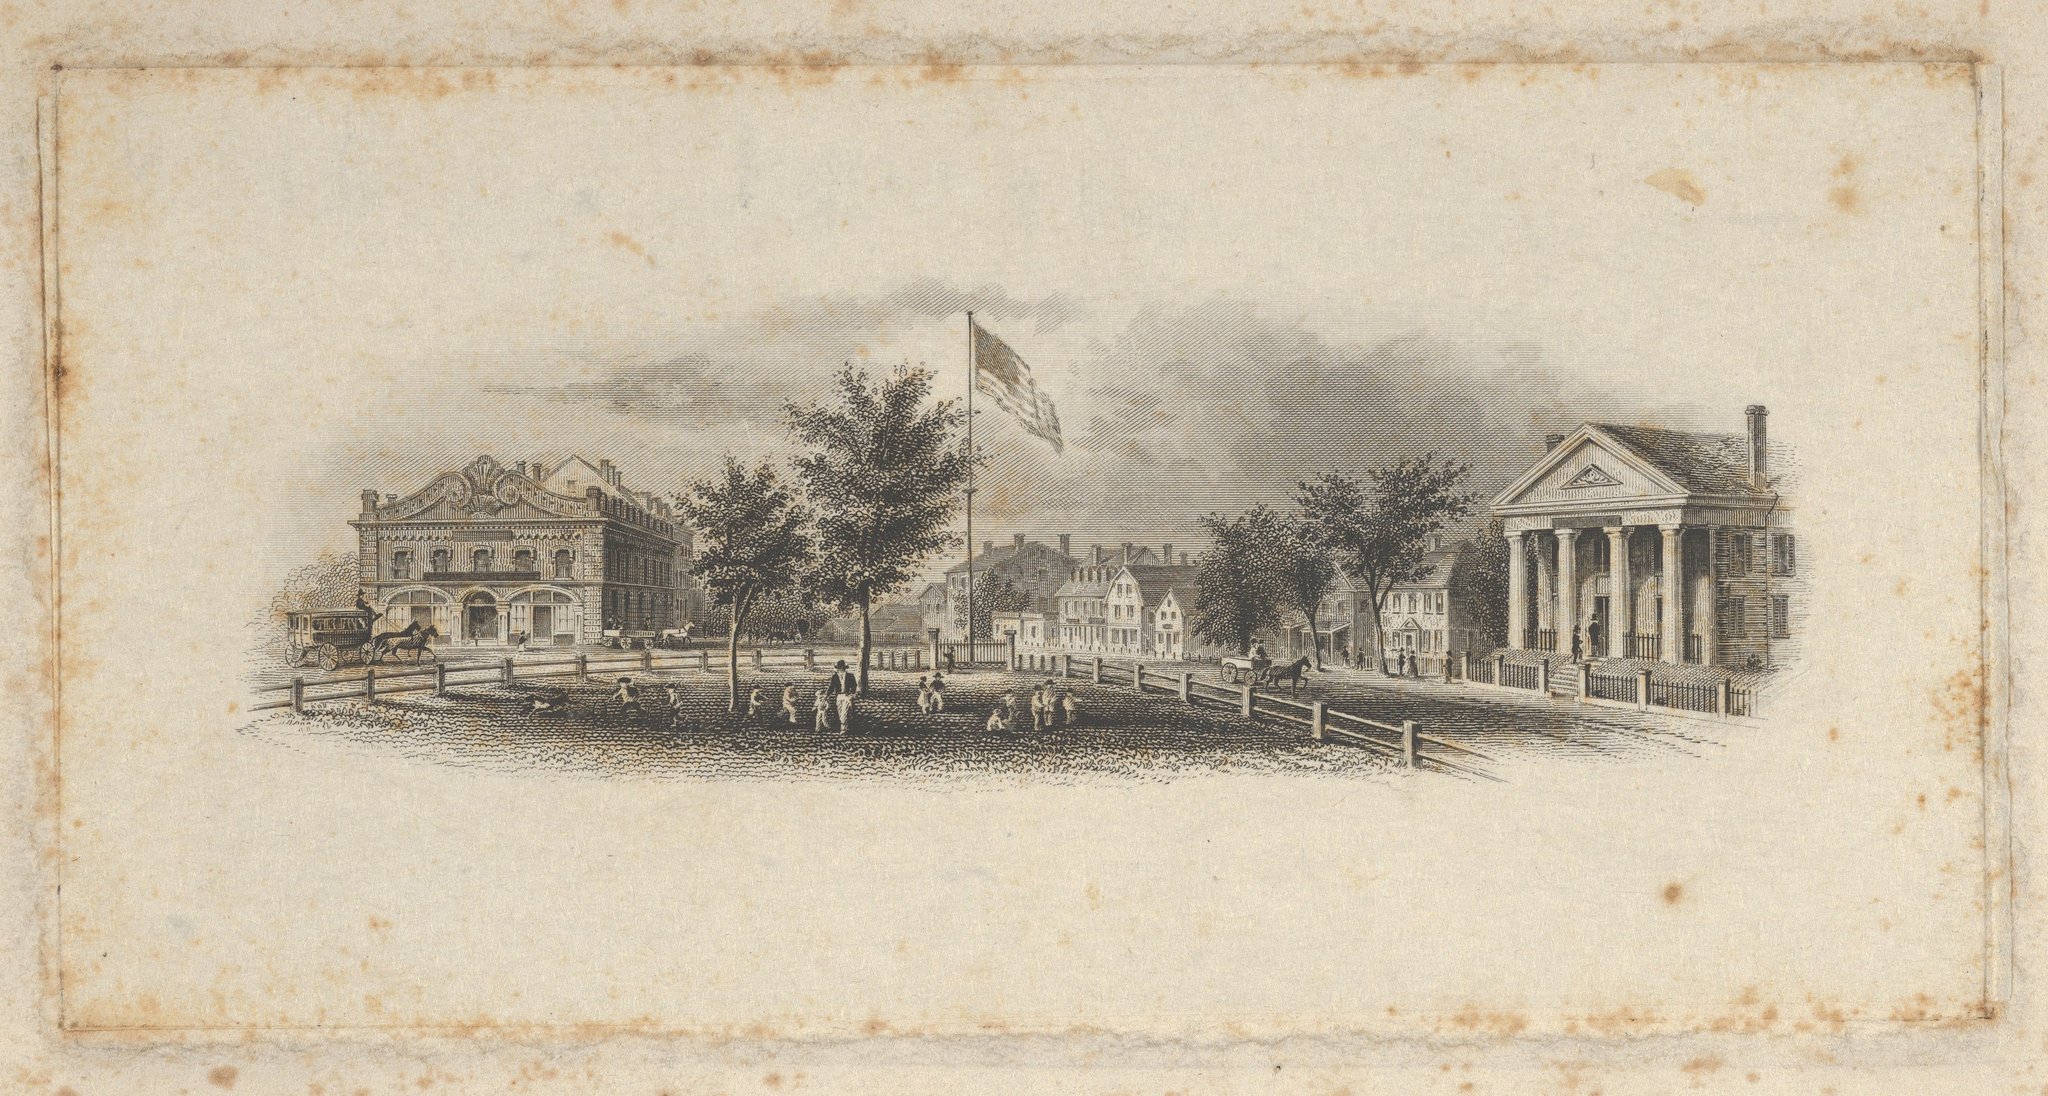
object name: print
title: Banknote vignette showing city buildings around a fenced-in green with children playing around an American flag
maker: asher brown durand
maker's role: artist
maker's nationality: american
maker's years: 1796-1886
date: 1824-1837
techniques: engraving, etching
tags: human figures,buildings,playing,flags